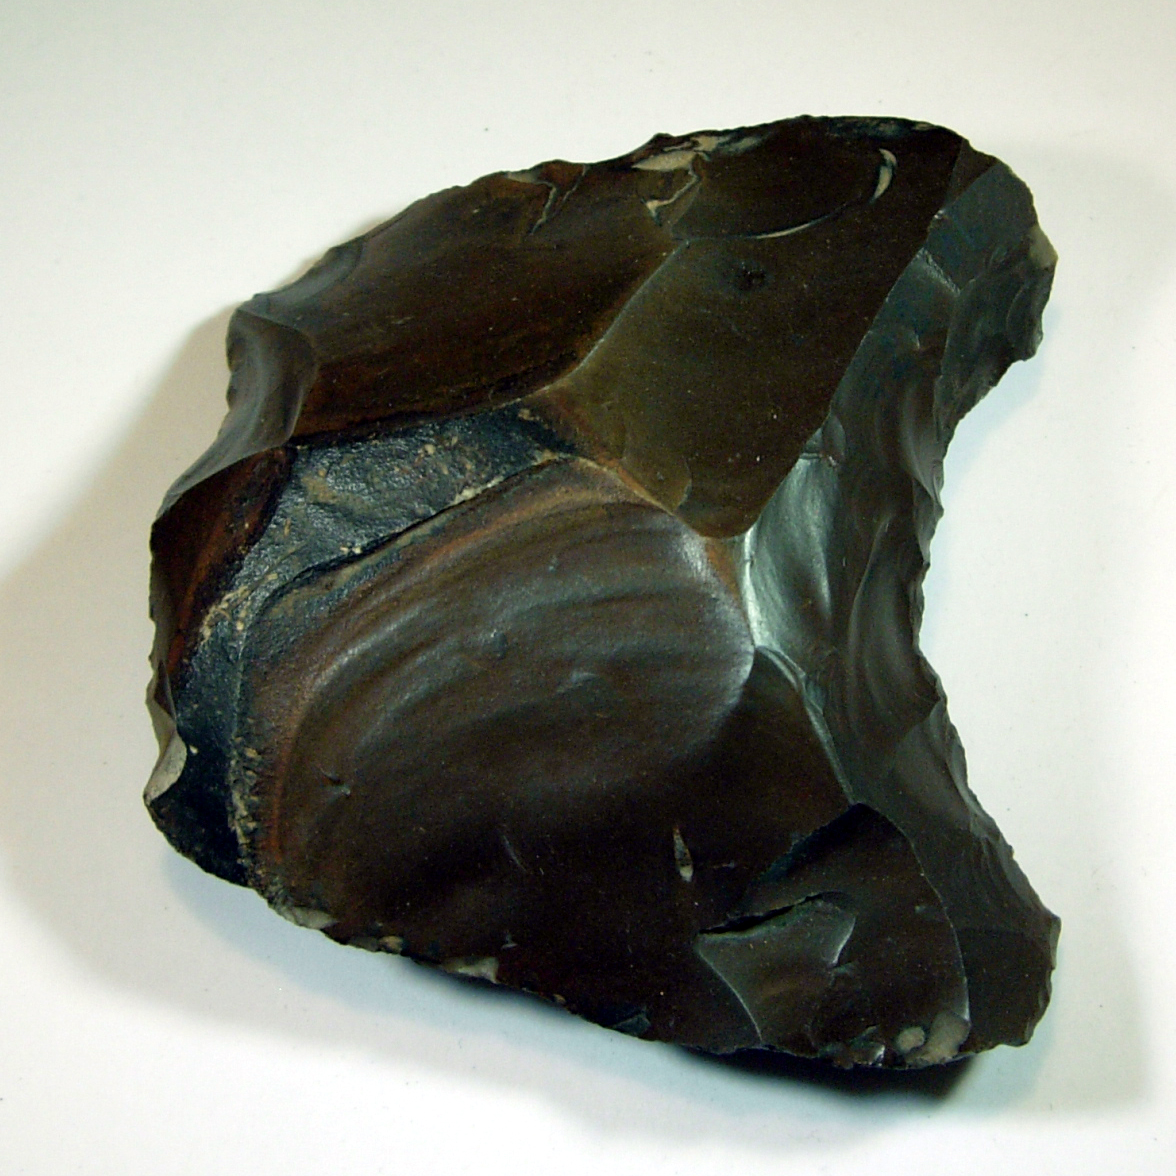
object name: tool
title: Tool (?)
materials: stone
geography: egypt